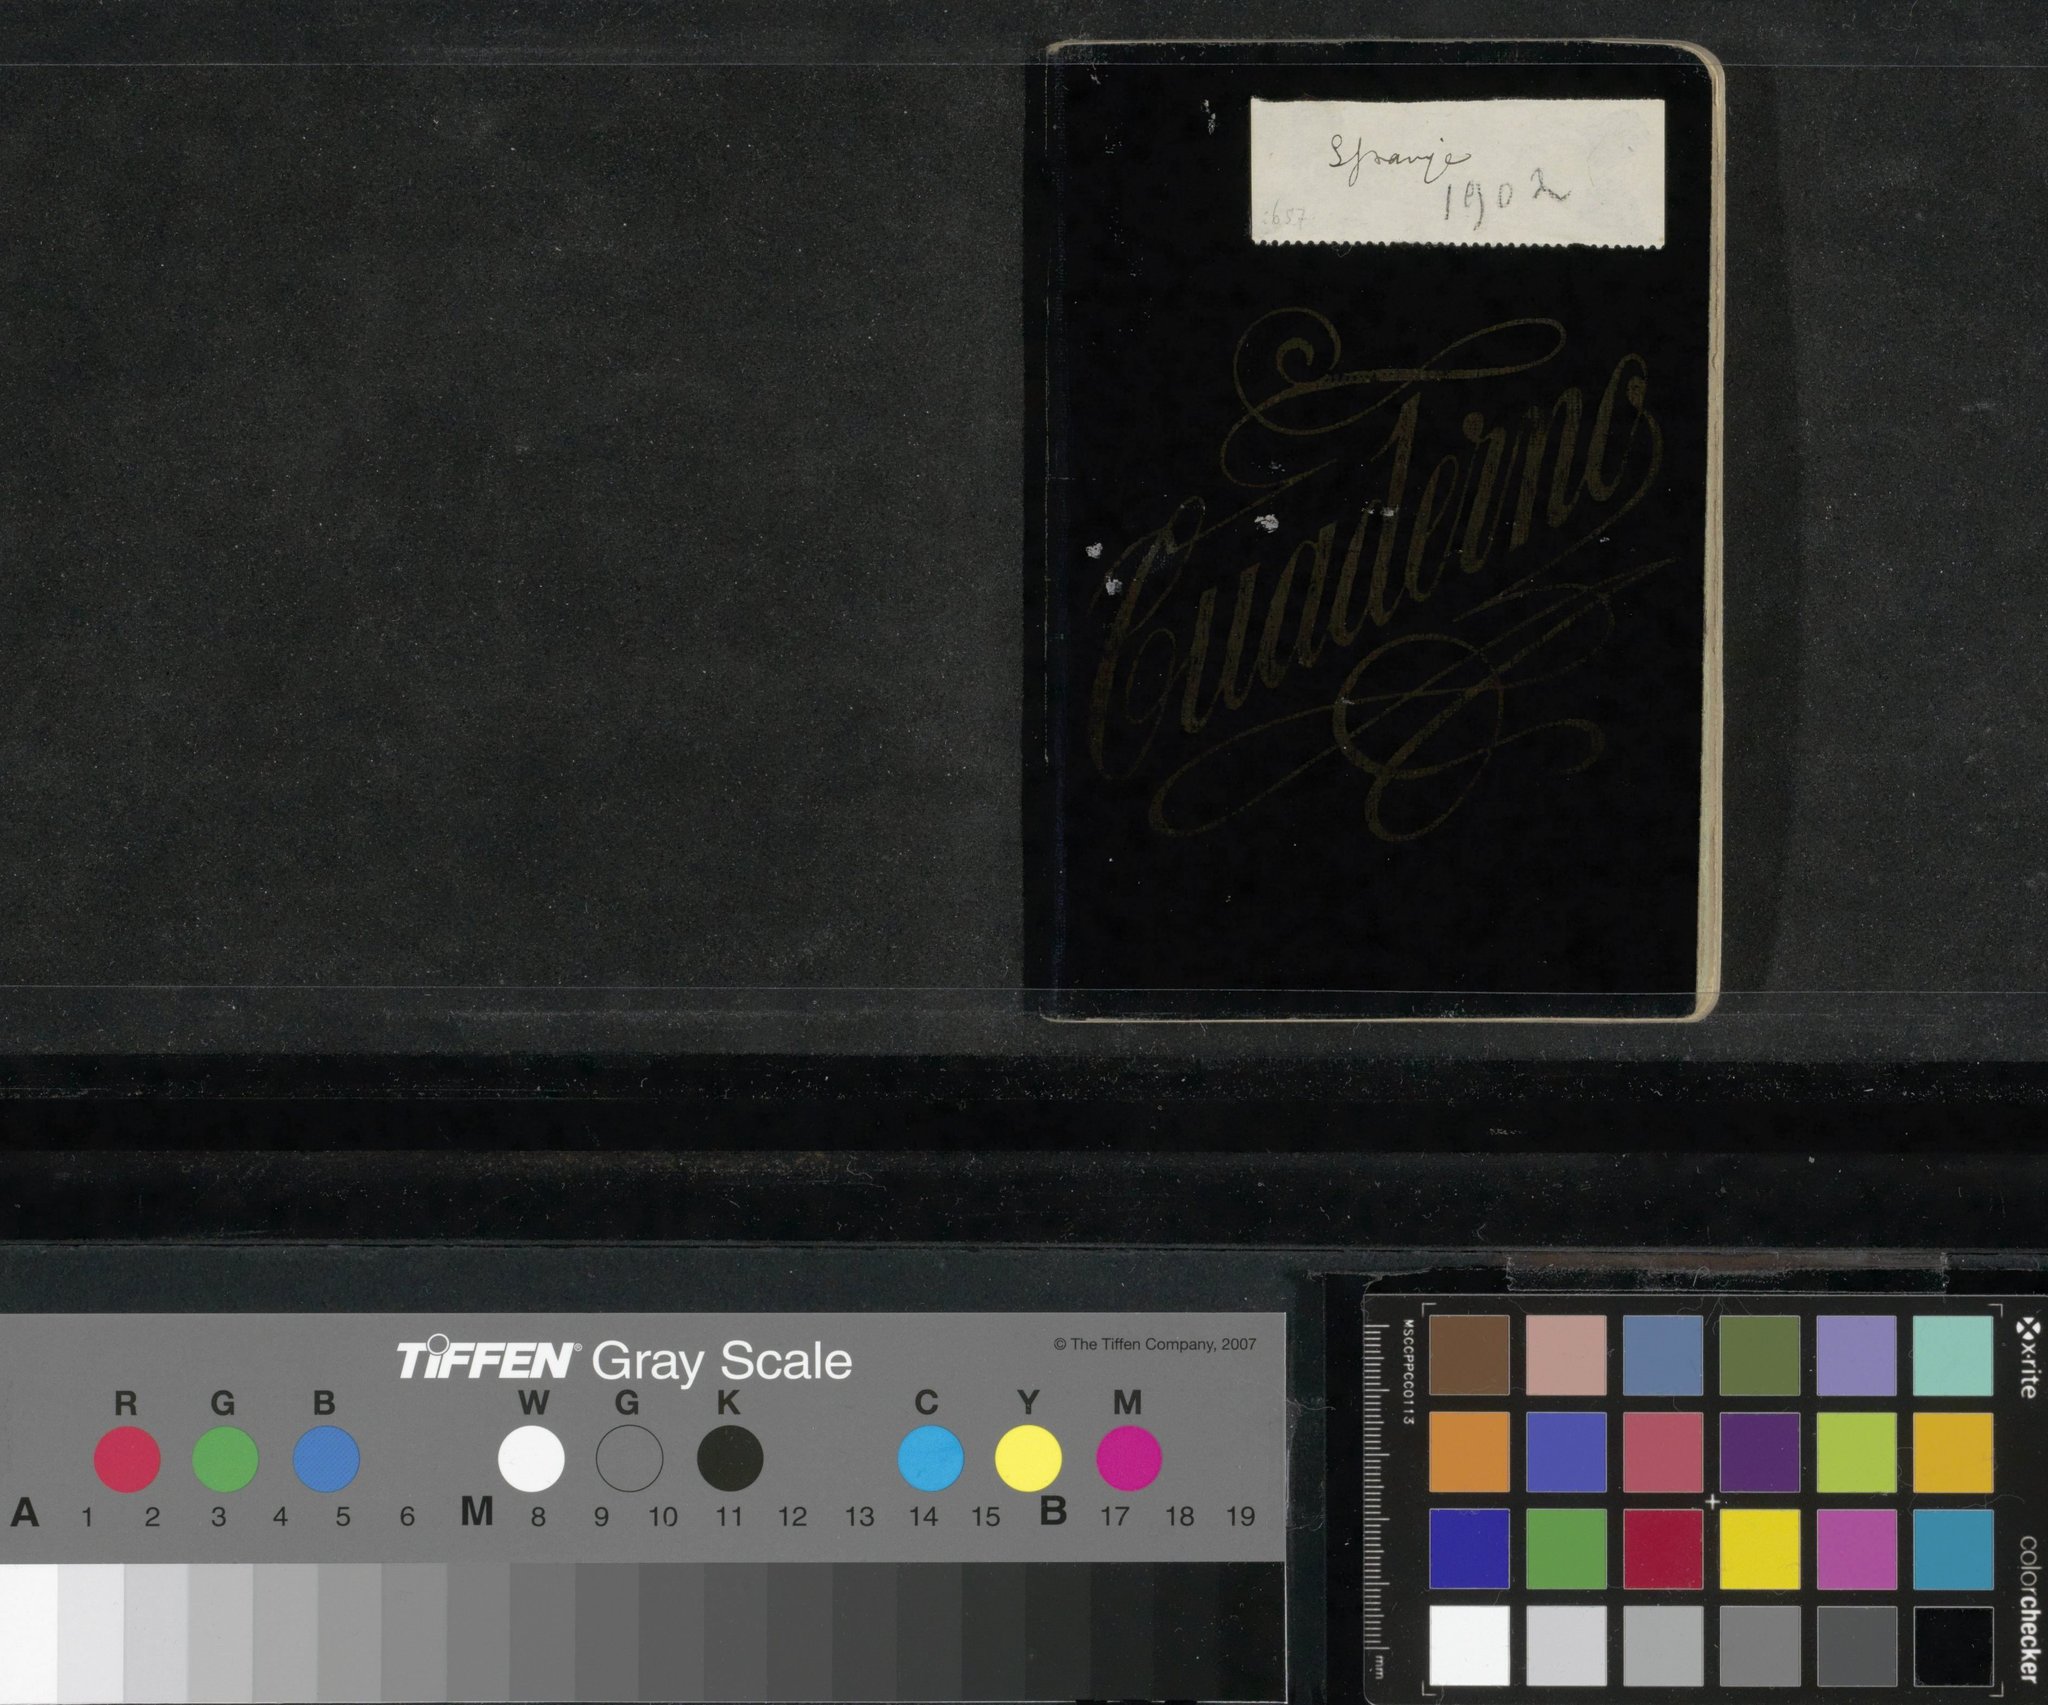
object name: sketchbook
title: Schetsboek met 50 bladen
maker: marius bauer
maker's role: draughtsman, print maker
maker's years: 1867-1932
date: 1902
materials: cardboard, linen, paper, pencil, watercolor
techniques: brush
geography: zaragoza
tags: city-view, and landscape with man-made constructions, church (exterior), interior of church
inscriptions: retailer's mark: ‘Cuaderno/ PAPELERIA DE PARIS/ J. ORTIGOSA/ Alcalá, 2/ MADRID/ IMPRENTA * LITOGRAFÍA/ ENCUADERNACIÓN/ NOVEDADES PARA REGALOS/ SURTIDO COMPLETO PARA OFICINAS’, collector's mark: Lugt 2228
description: Schetsboek bestaande uit 50 bladen met schetsen gemaakt tijdens een reis door Spanje met voornamelijk stadsgezichten, landschappen, kerken en kerkinterieurs in Avila, Toledo, Zaragoza en Girona.